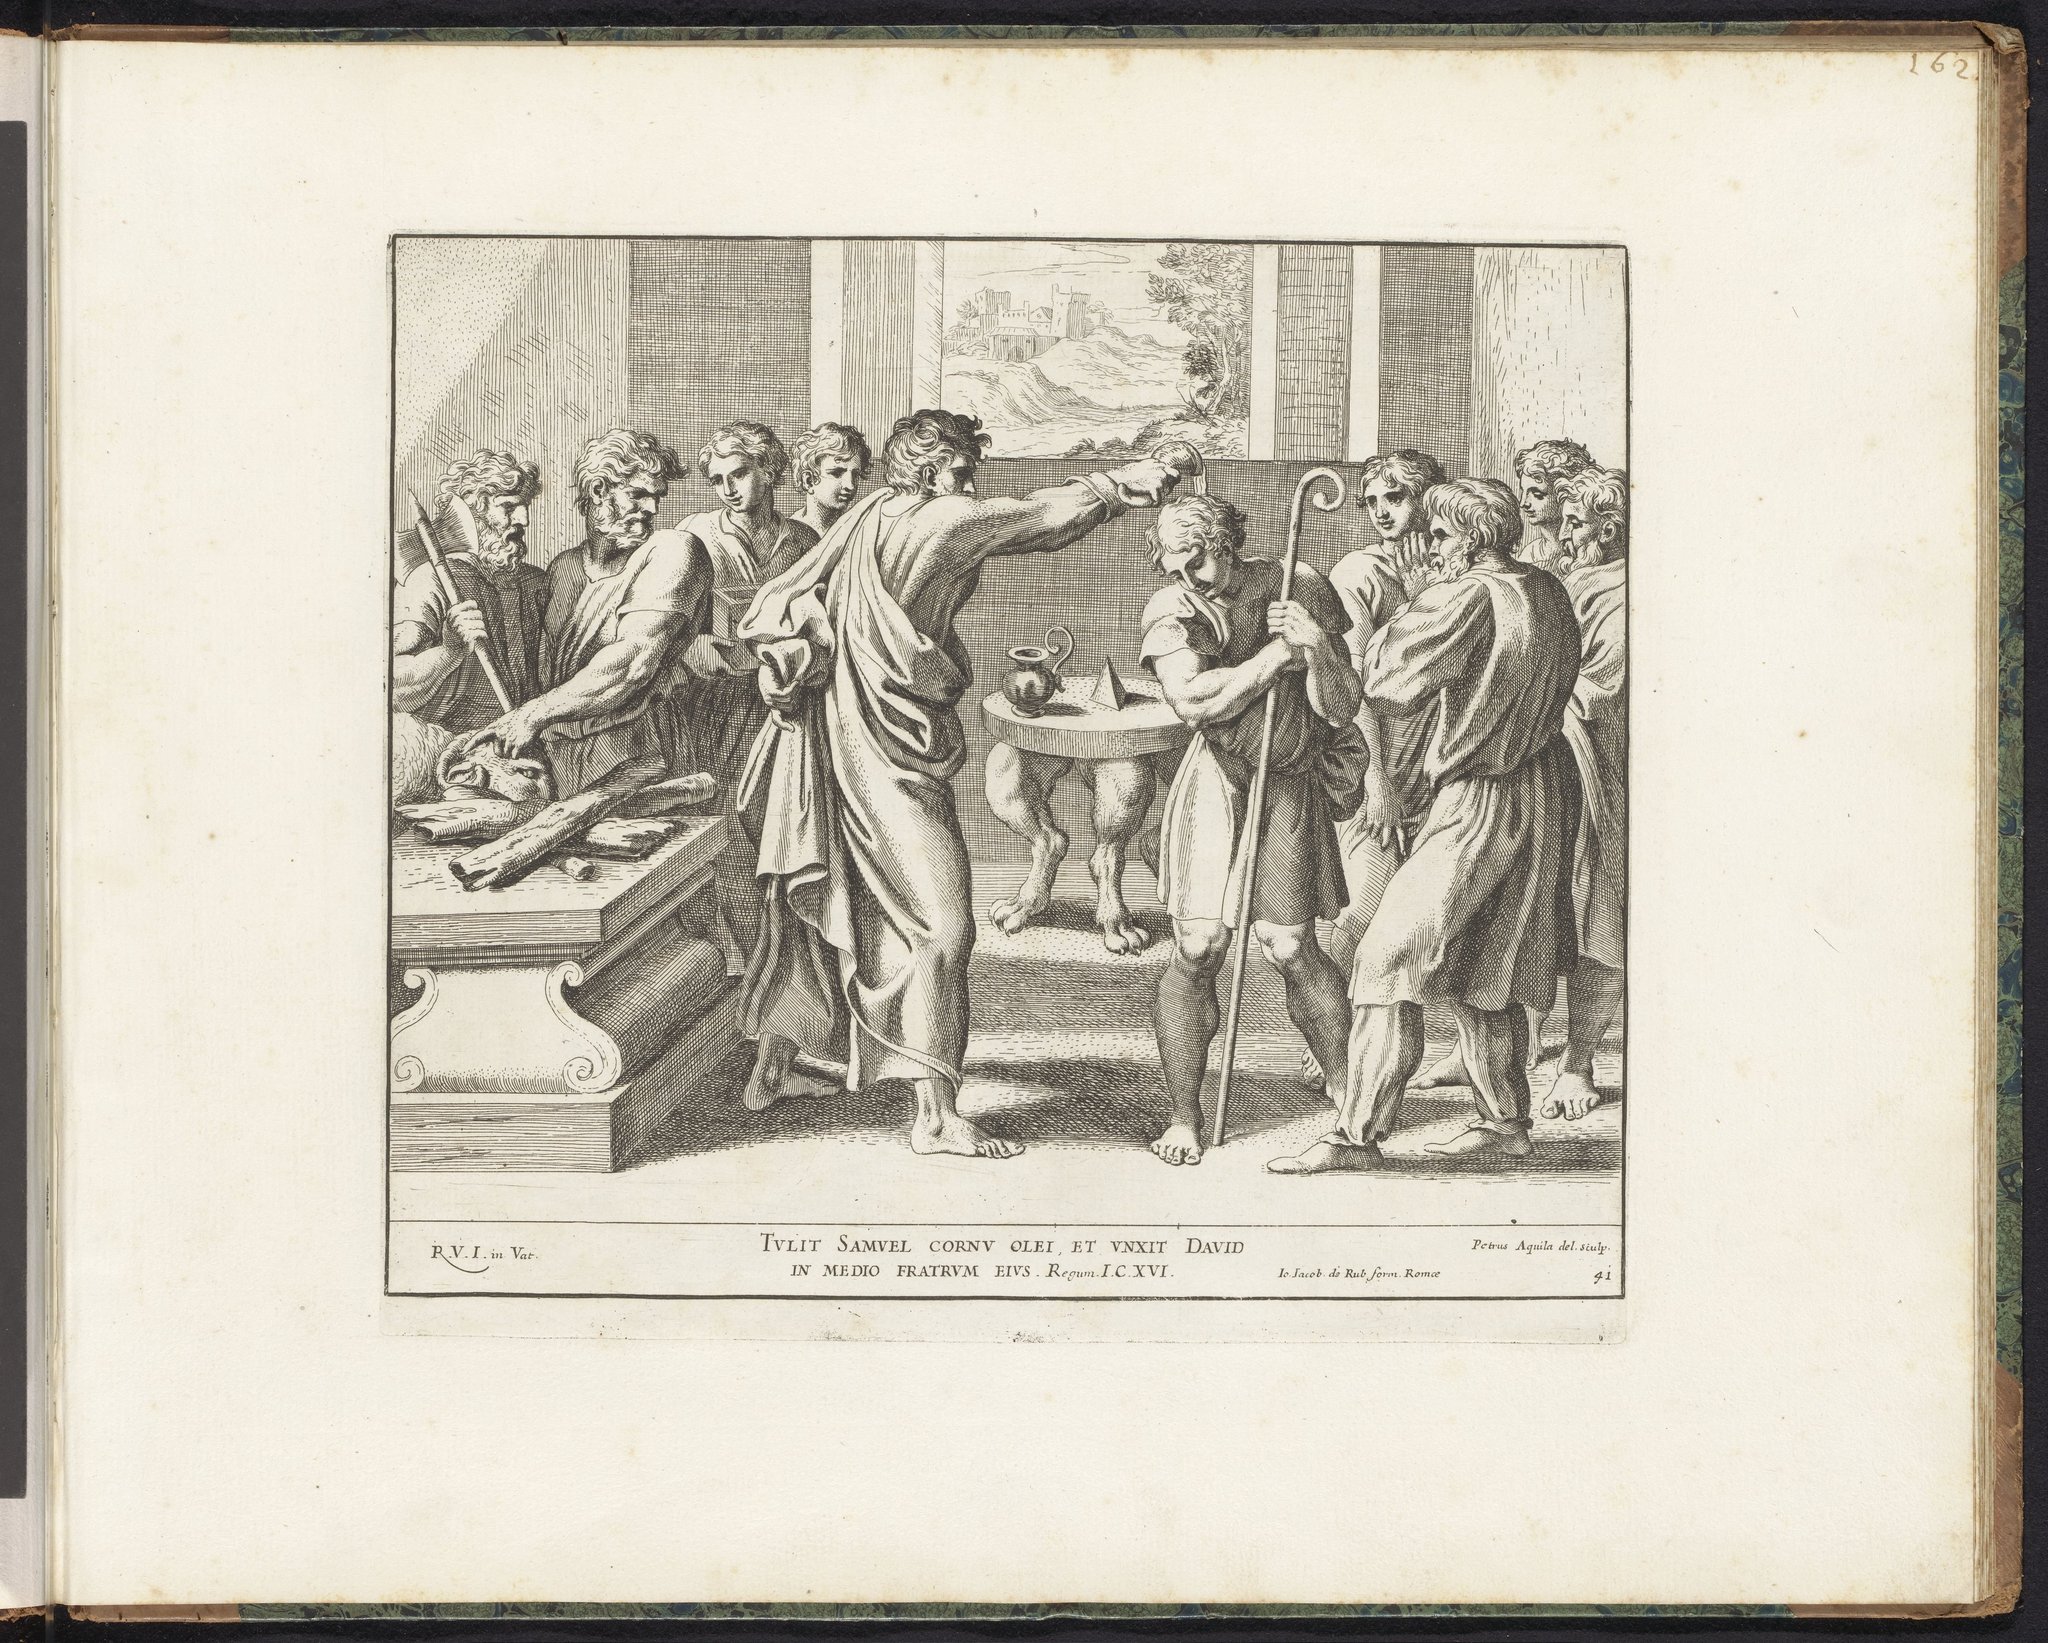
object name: print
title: Schilderingen in de Loggia van Rafaël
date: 1675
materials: paper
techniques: etching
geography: vatican city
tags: samuel anointing david in the presence of his father jesse and his brothers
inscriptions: number: ‘162’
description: Zicht in een vertrek waar Samuel David zalft. Achter Samuel staan vier figuren en achter David staan nog eens vier figuren. Op de voorgrond links een altaar. Bijbelvers onder de voorstelling. Prent maakt deel uit van een album.